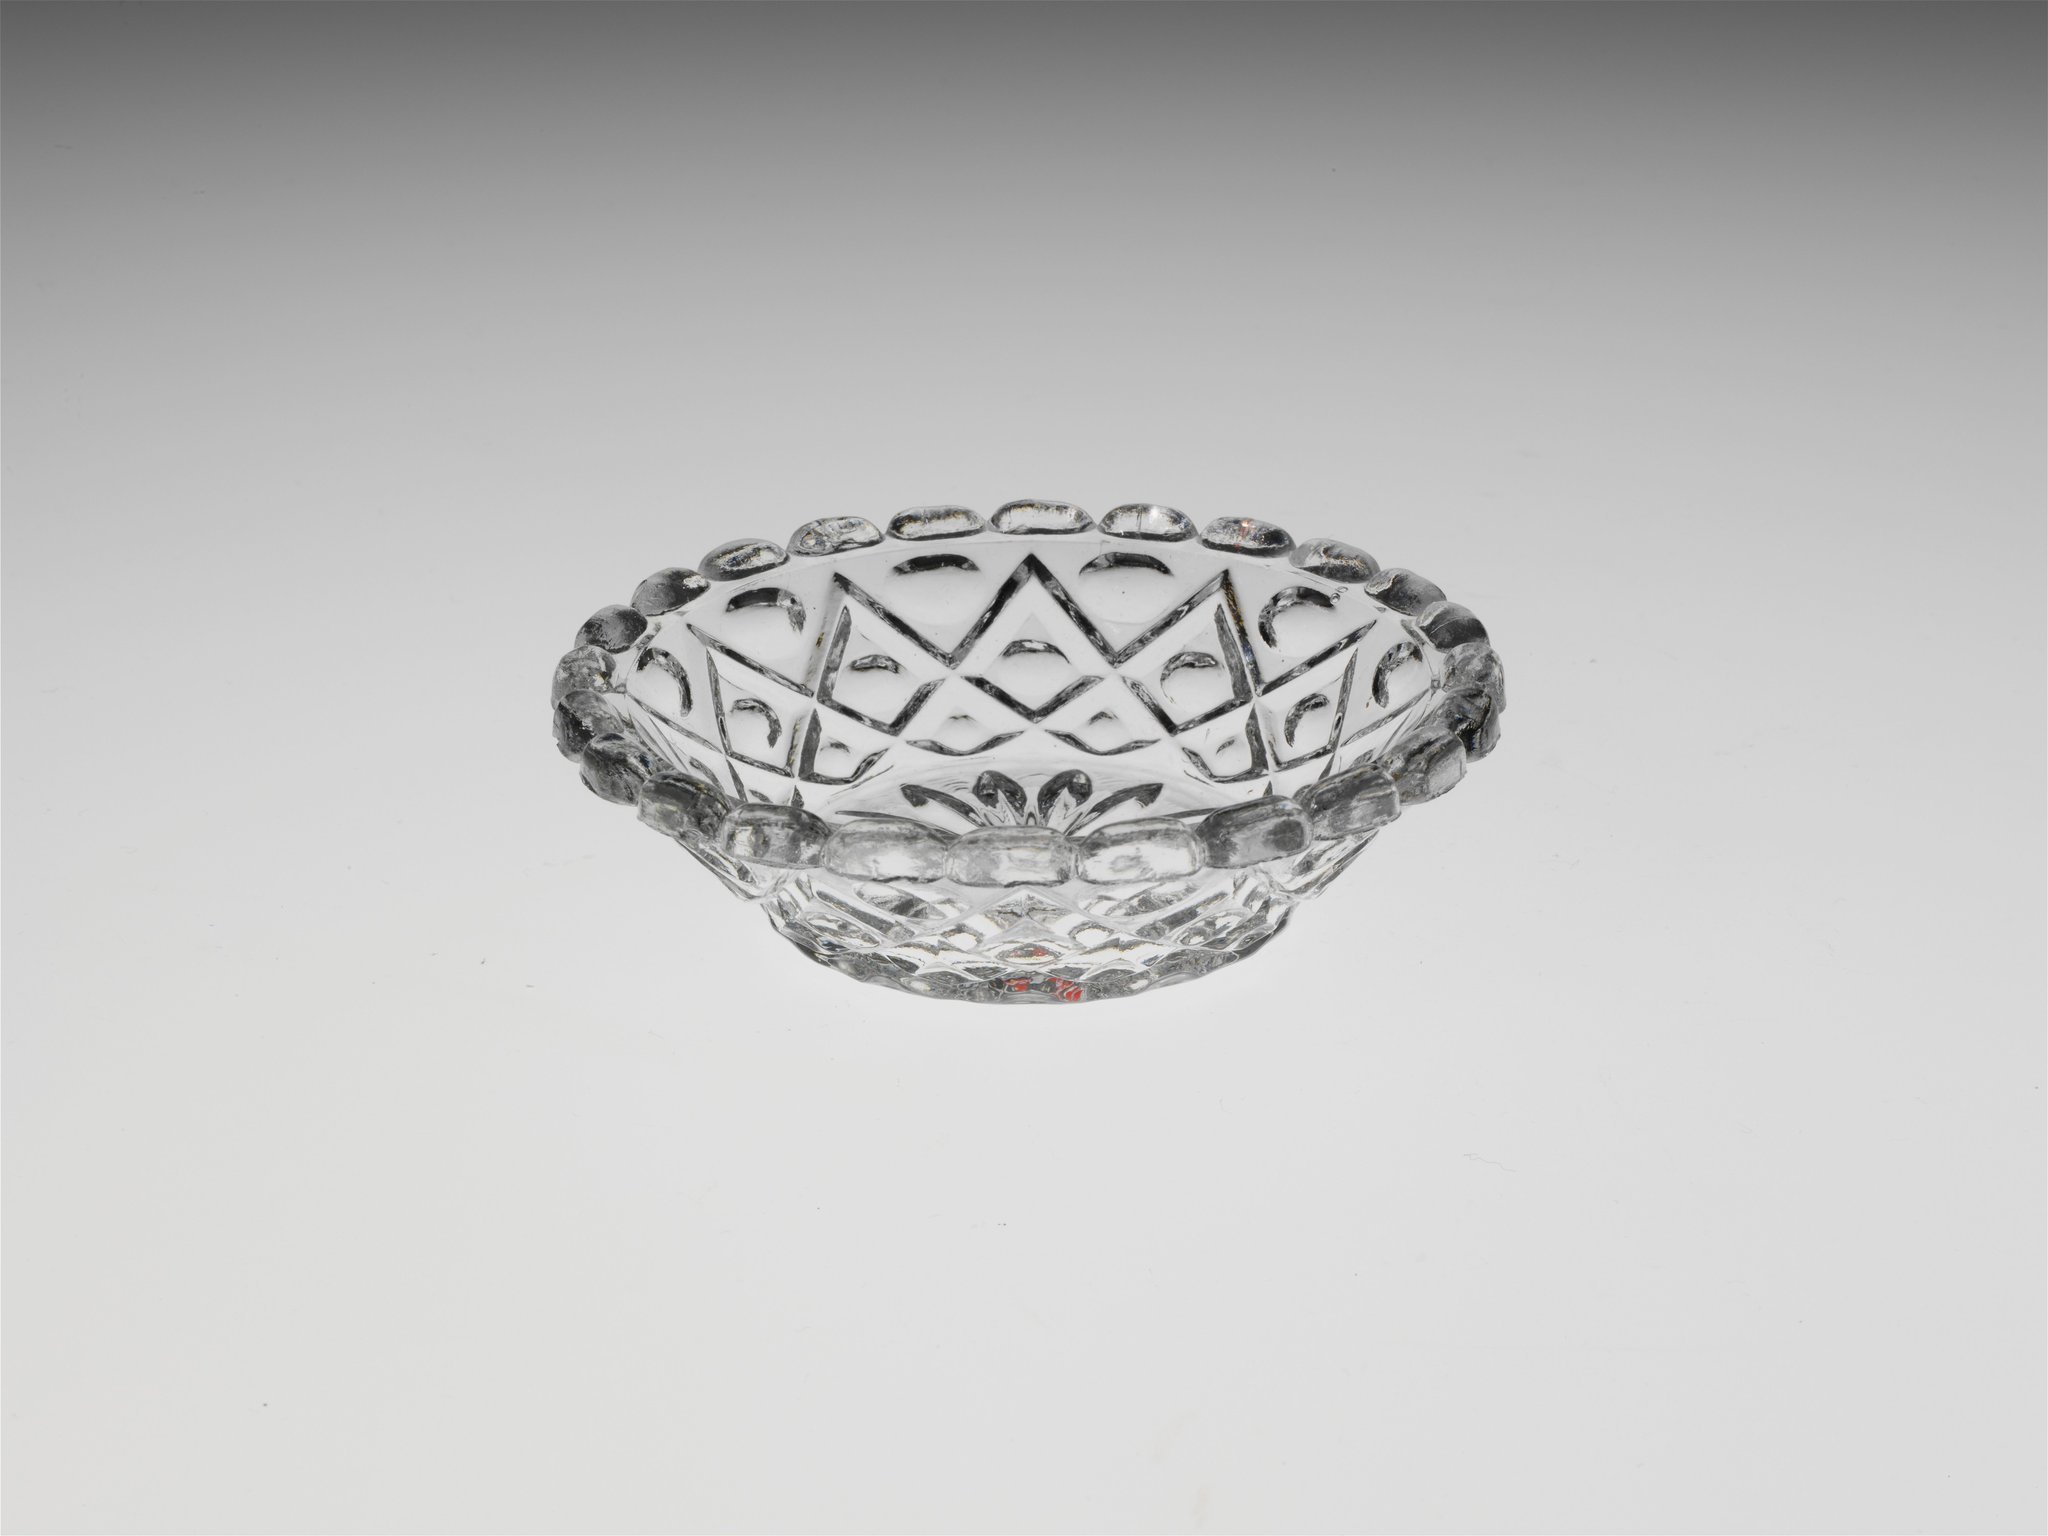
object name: honey dish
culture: american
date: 1850-1860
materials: diamond, glass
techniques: pressed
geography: united states